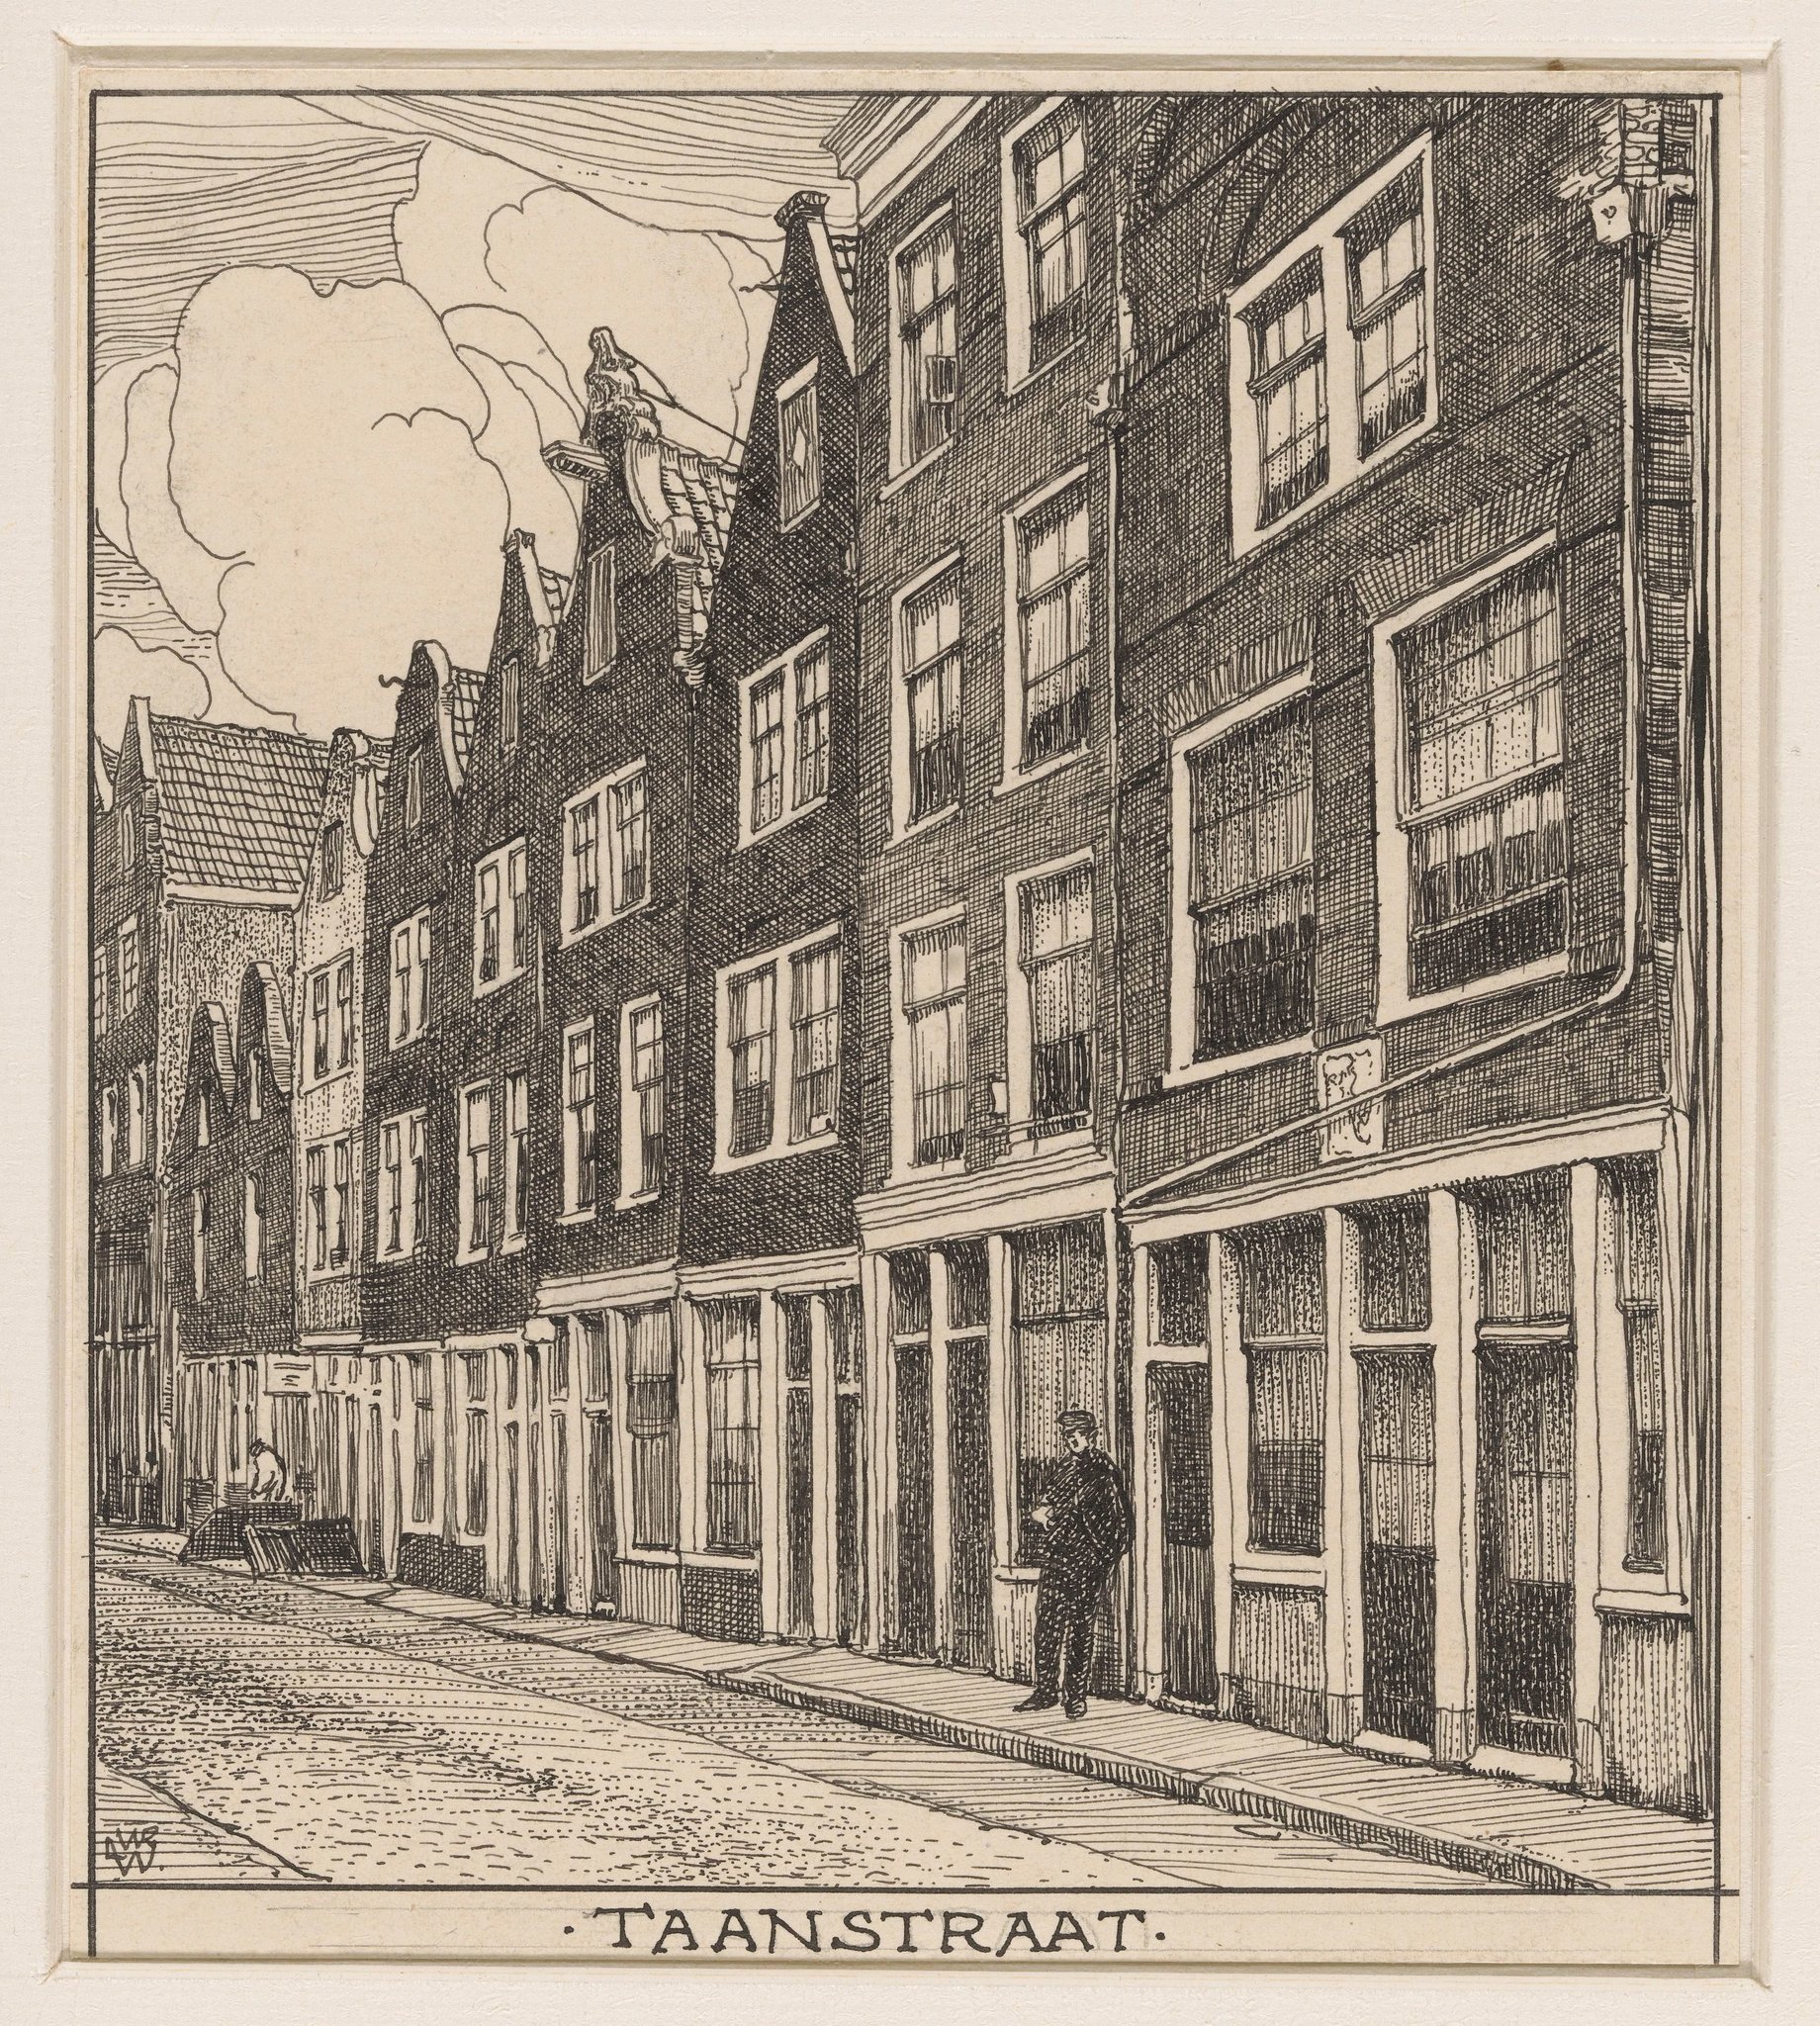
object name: drawing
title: Taanstraat te Amsterdam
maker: willem wenckebach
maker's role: designer, draughtsman, painter, print maker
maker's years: 1860-1937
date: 1870-1926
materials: ink, paper, pencil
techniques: pen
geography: amsterdam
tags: street, amsterdam